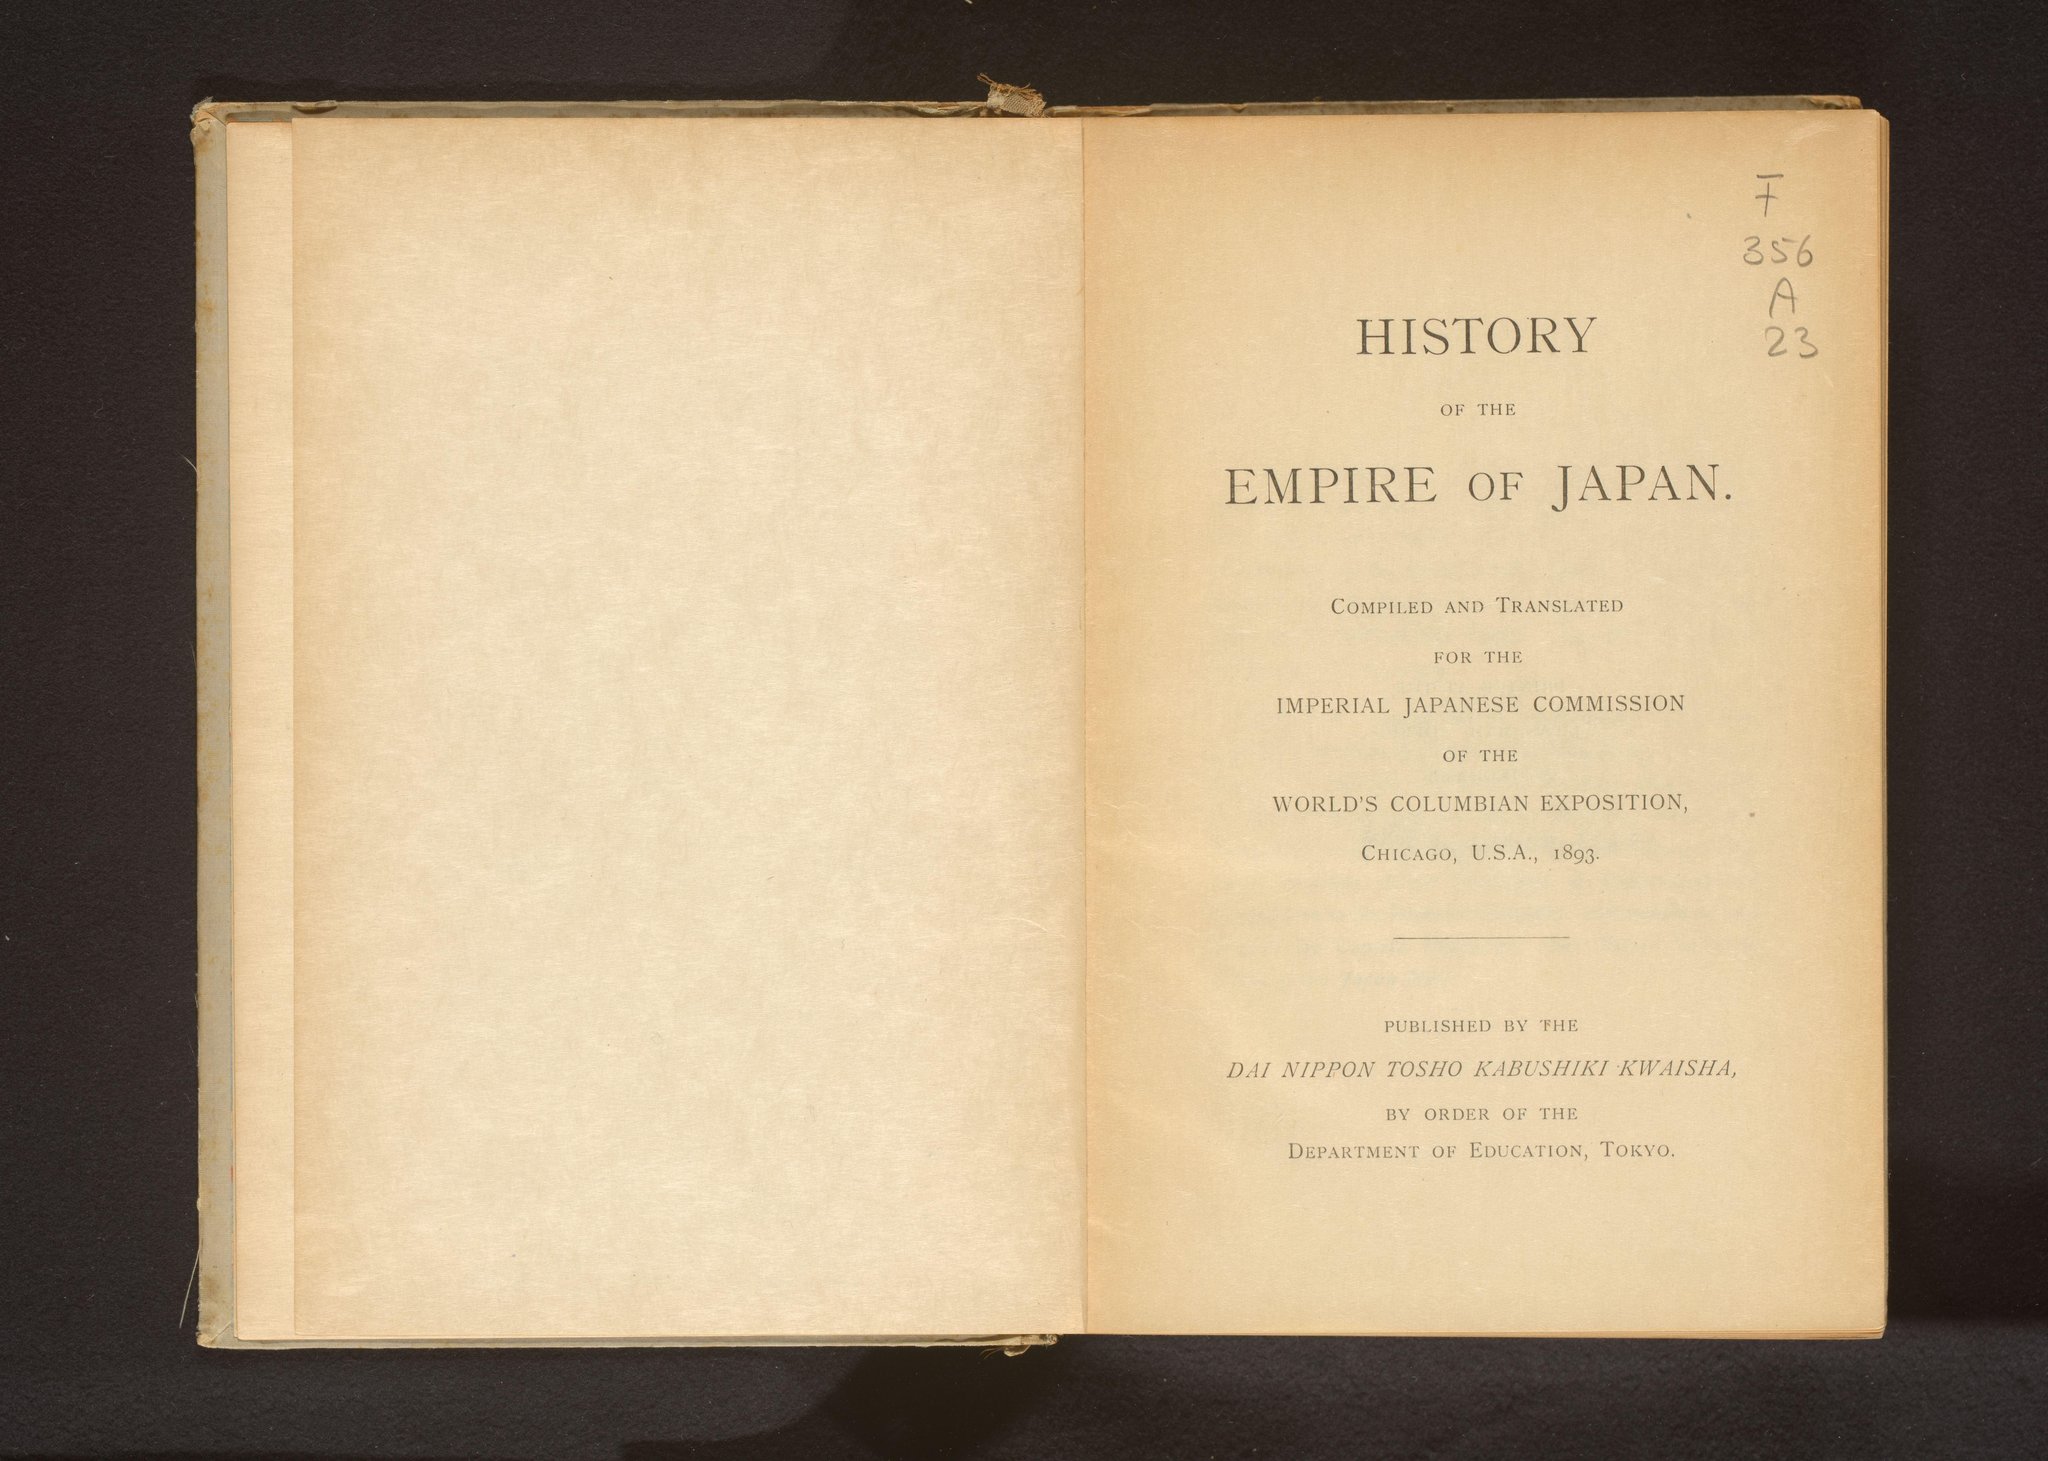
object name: book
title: History of the empire of Japan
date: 1893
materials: cardboard, paper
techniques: photograph, printing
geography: tokyo